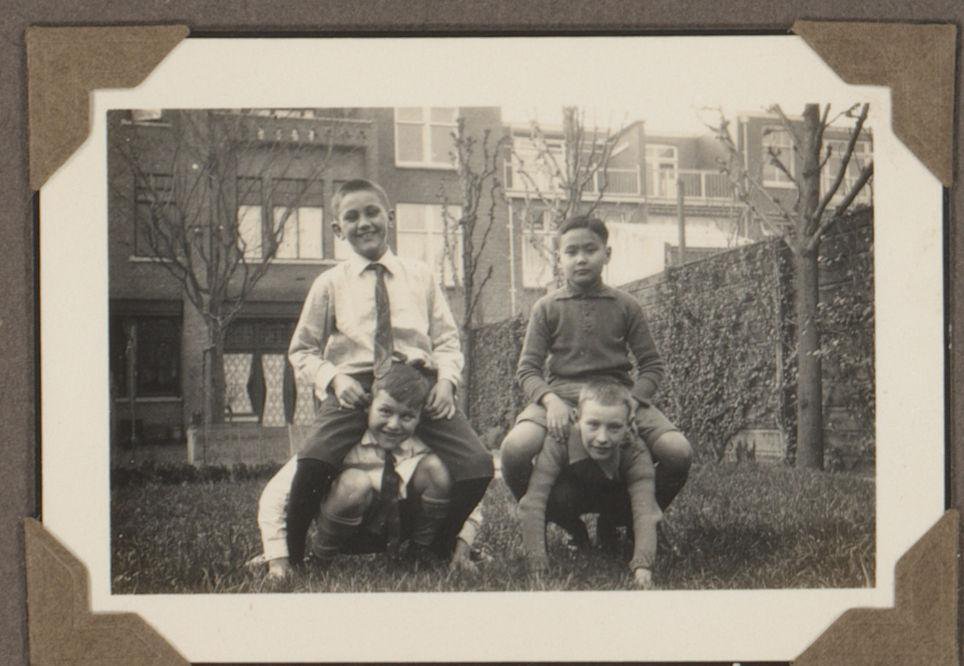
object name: photograph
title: Dicky Baud en drie andere jongens spelend in een tuin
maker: Anonymous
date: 1930-1935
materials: paper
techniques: gelatin silver print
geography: netherlands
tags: children's games and plays, boy (child between toddler and youth), netherlands